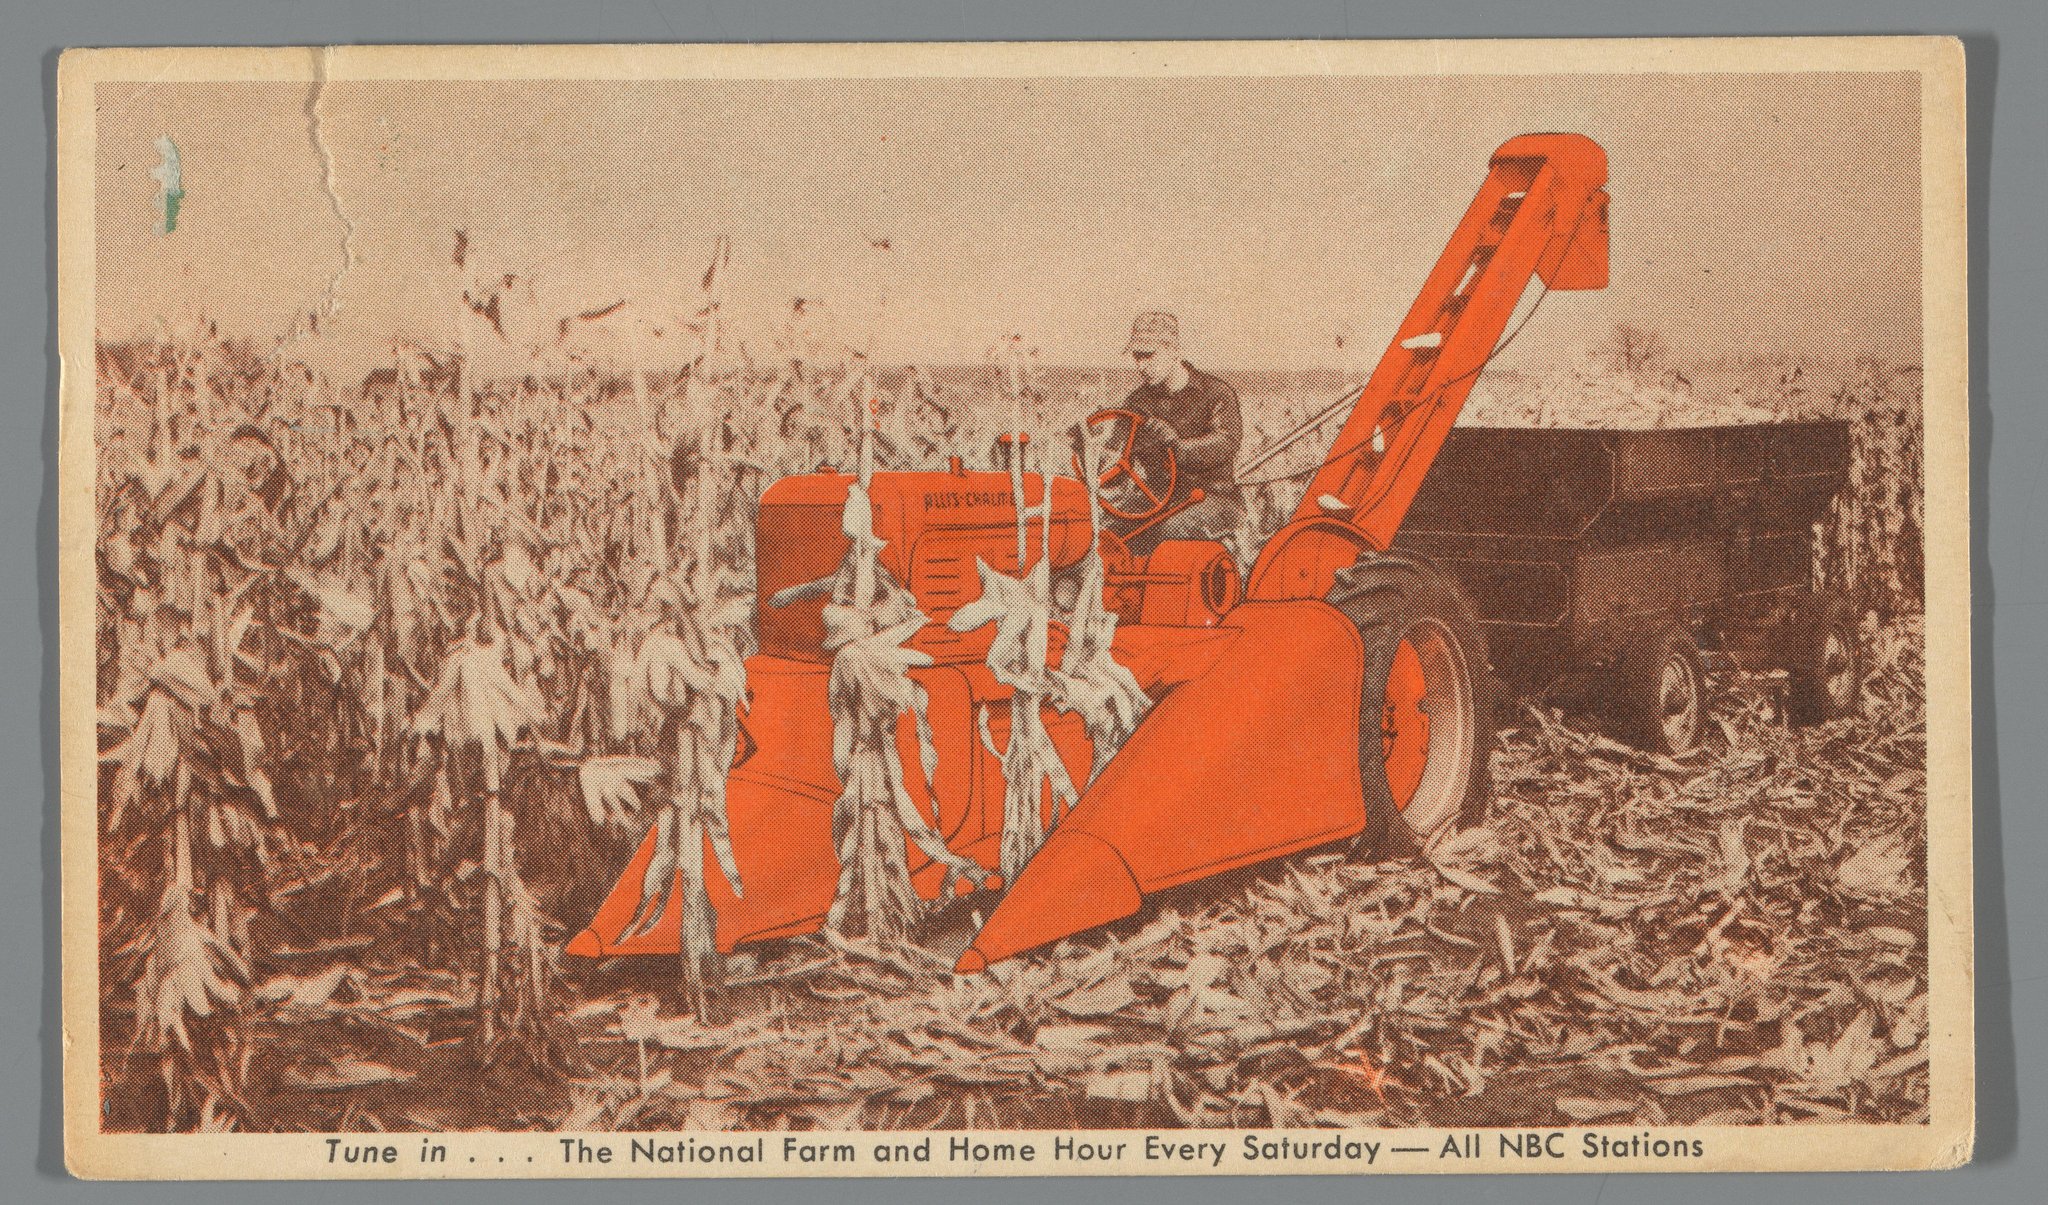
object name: ansichtkaart, prentbriefkaart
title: Landbouwmachine/maaidorser/katoenplukmachine van het merk Allis-Chalmers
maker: Anonymous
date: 1940-1950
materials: cardboard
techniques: autotype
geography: united states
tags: united states of america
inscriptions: inscription: ‘Tune in … The National Farm and Home Hour Every Saturday – All NBC Stations’, : ‘1948’, inscription: ‘TWO-ROW CORN HARVESTER […] / Printed in U.S. of A. / No. 3’